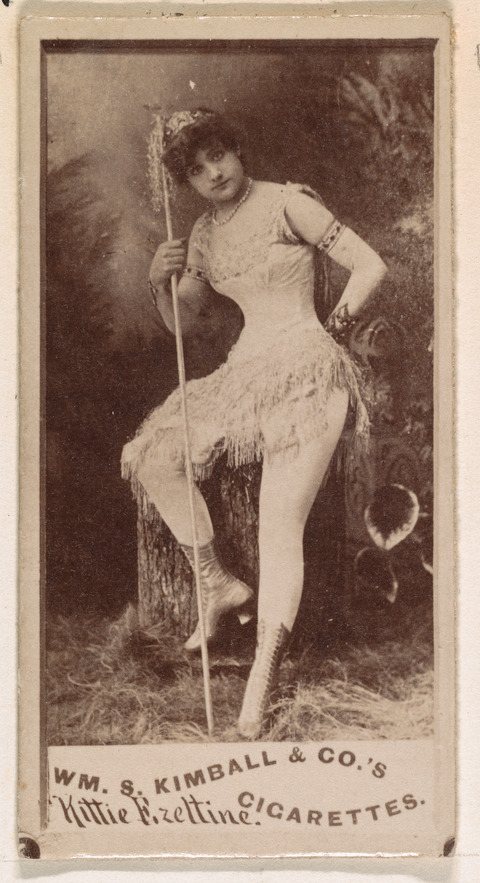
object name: photograph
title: Kittie Fizeltine, from the Actresses series (N203) issued by Wm. S. Kimball & Co.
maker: william s. kimball & company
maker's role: publisher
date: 1889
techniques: color lithograph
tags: portraits,women,actresses